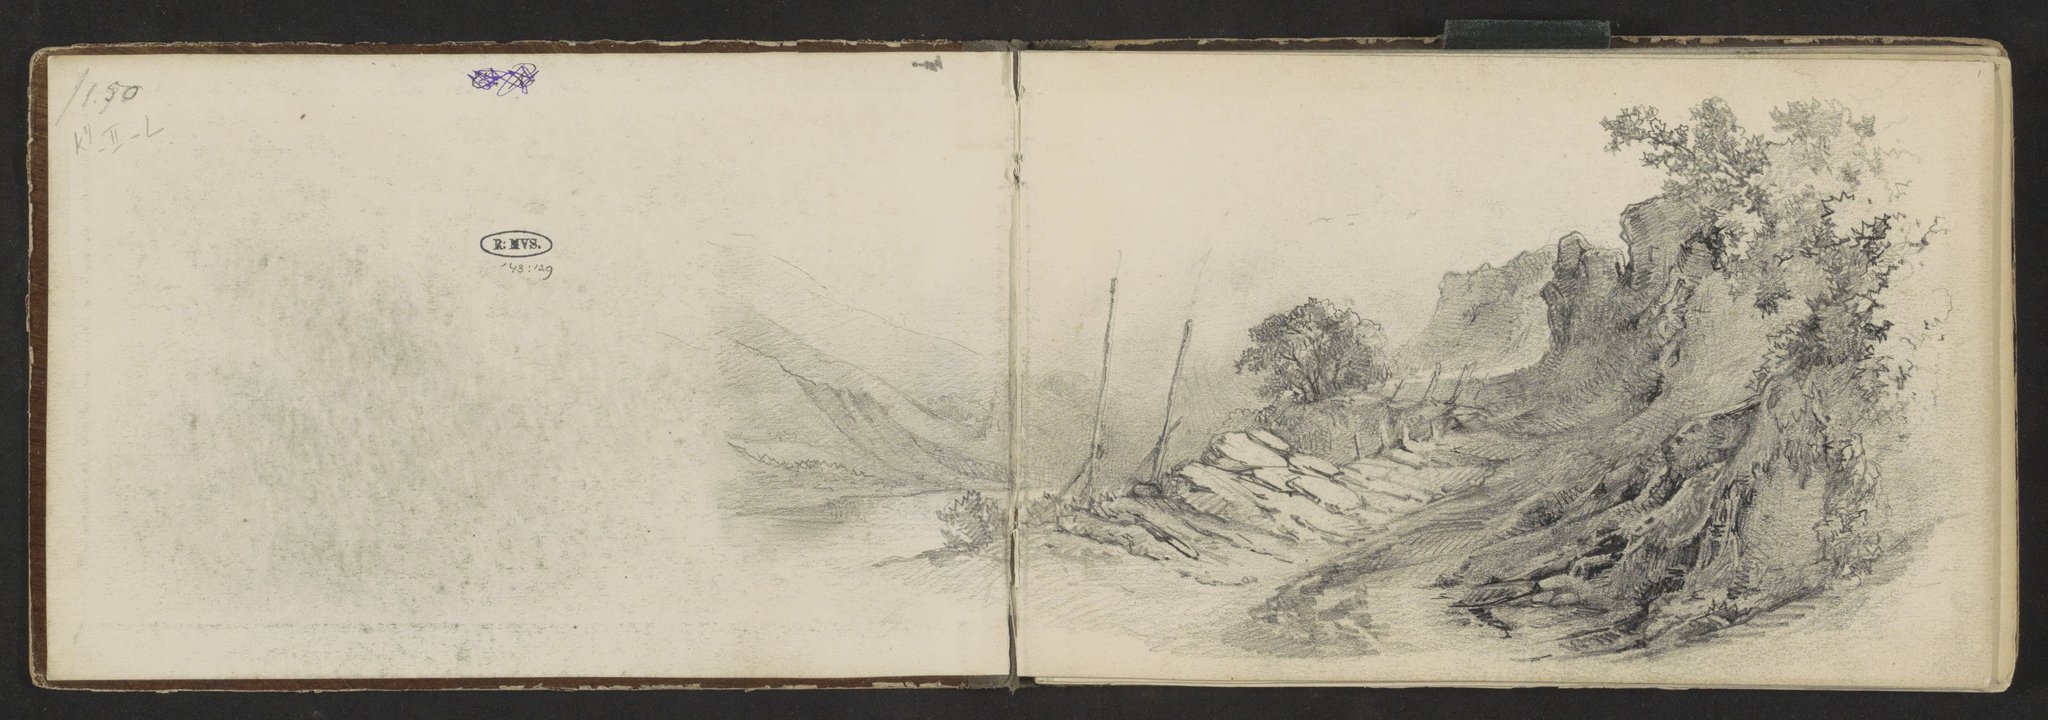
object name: sketchbook leaf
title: Landschap met bergen, rotsen en een pad langs een waterweg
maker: maria vos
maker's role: draughtsman, painter, print maker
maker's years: 1824-1906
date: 1871-1878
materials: paper, pencil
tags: landscapes with waters, waterscapes, seascapes (in the temperate zone), mountains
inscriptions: collector's mark: Lugt L2228a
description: Voorste schutblad en pagina 1 recto uit een schetsboek met 45 bladen.